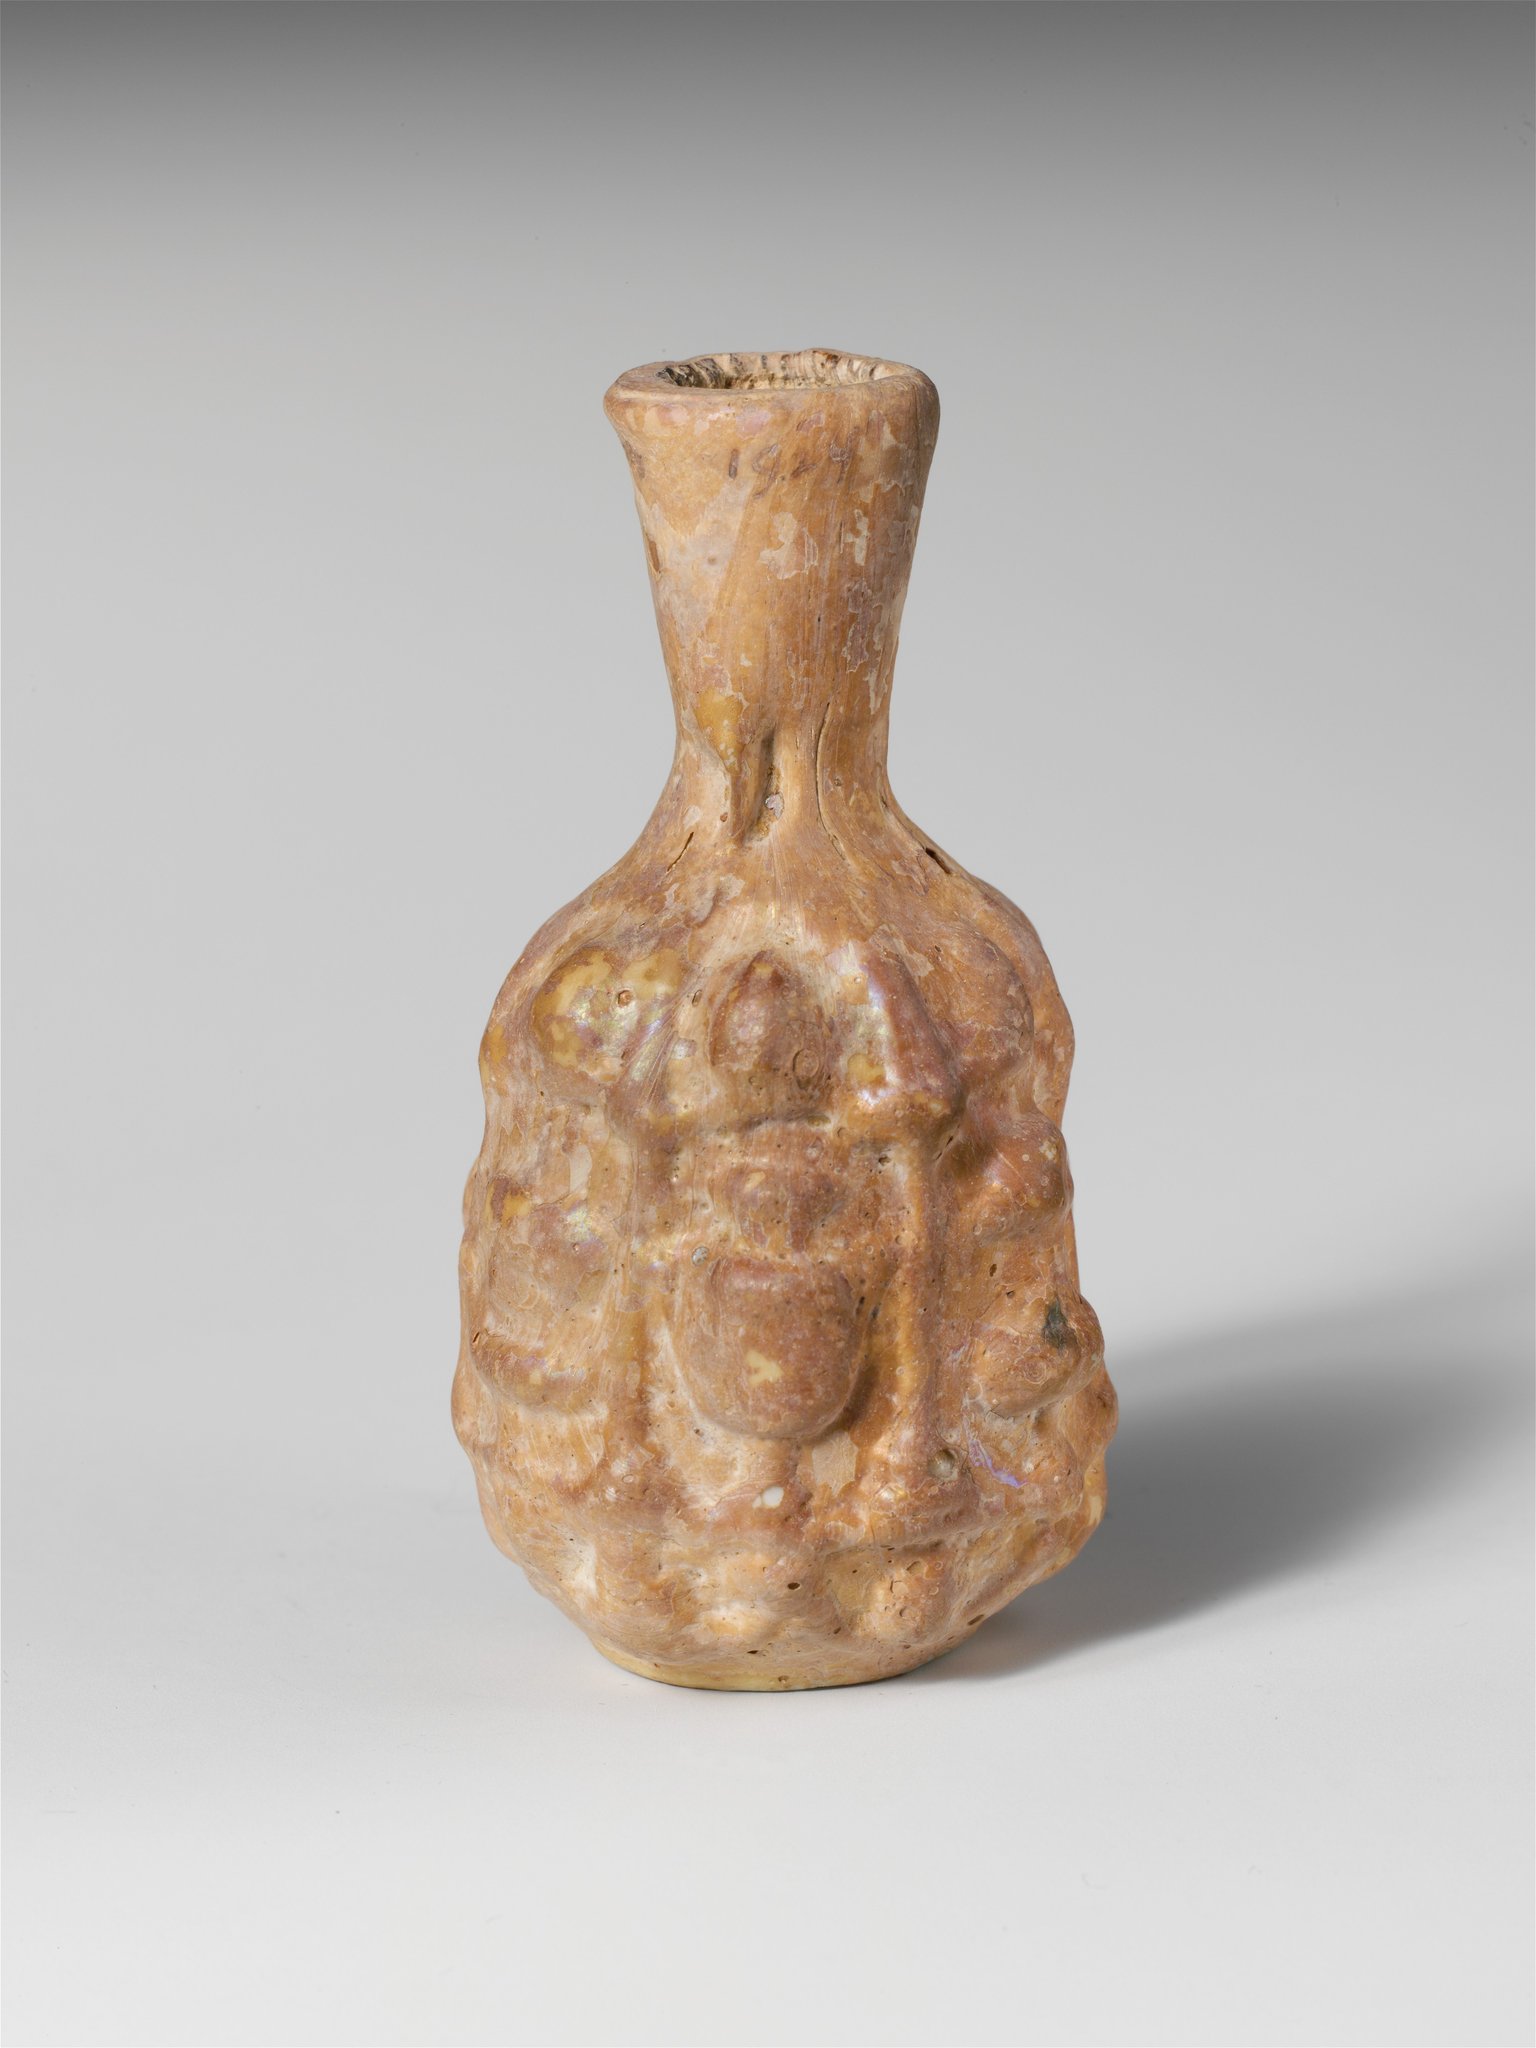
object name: bottle, hexagonal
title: Glass hexagonal bottle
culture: roman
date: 1-100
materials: glass